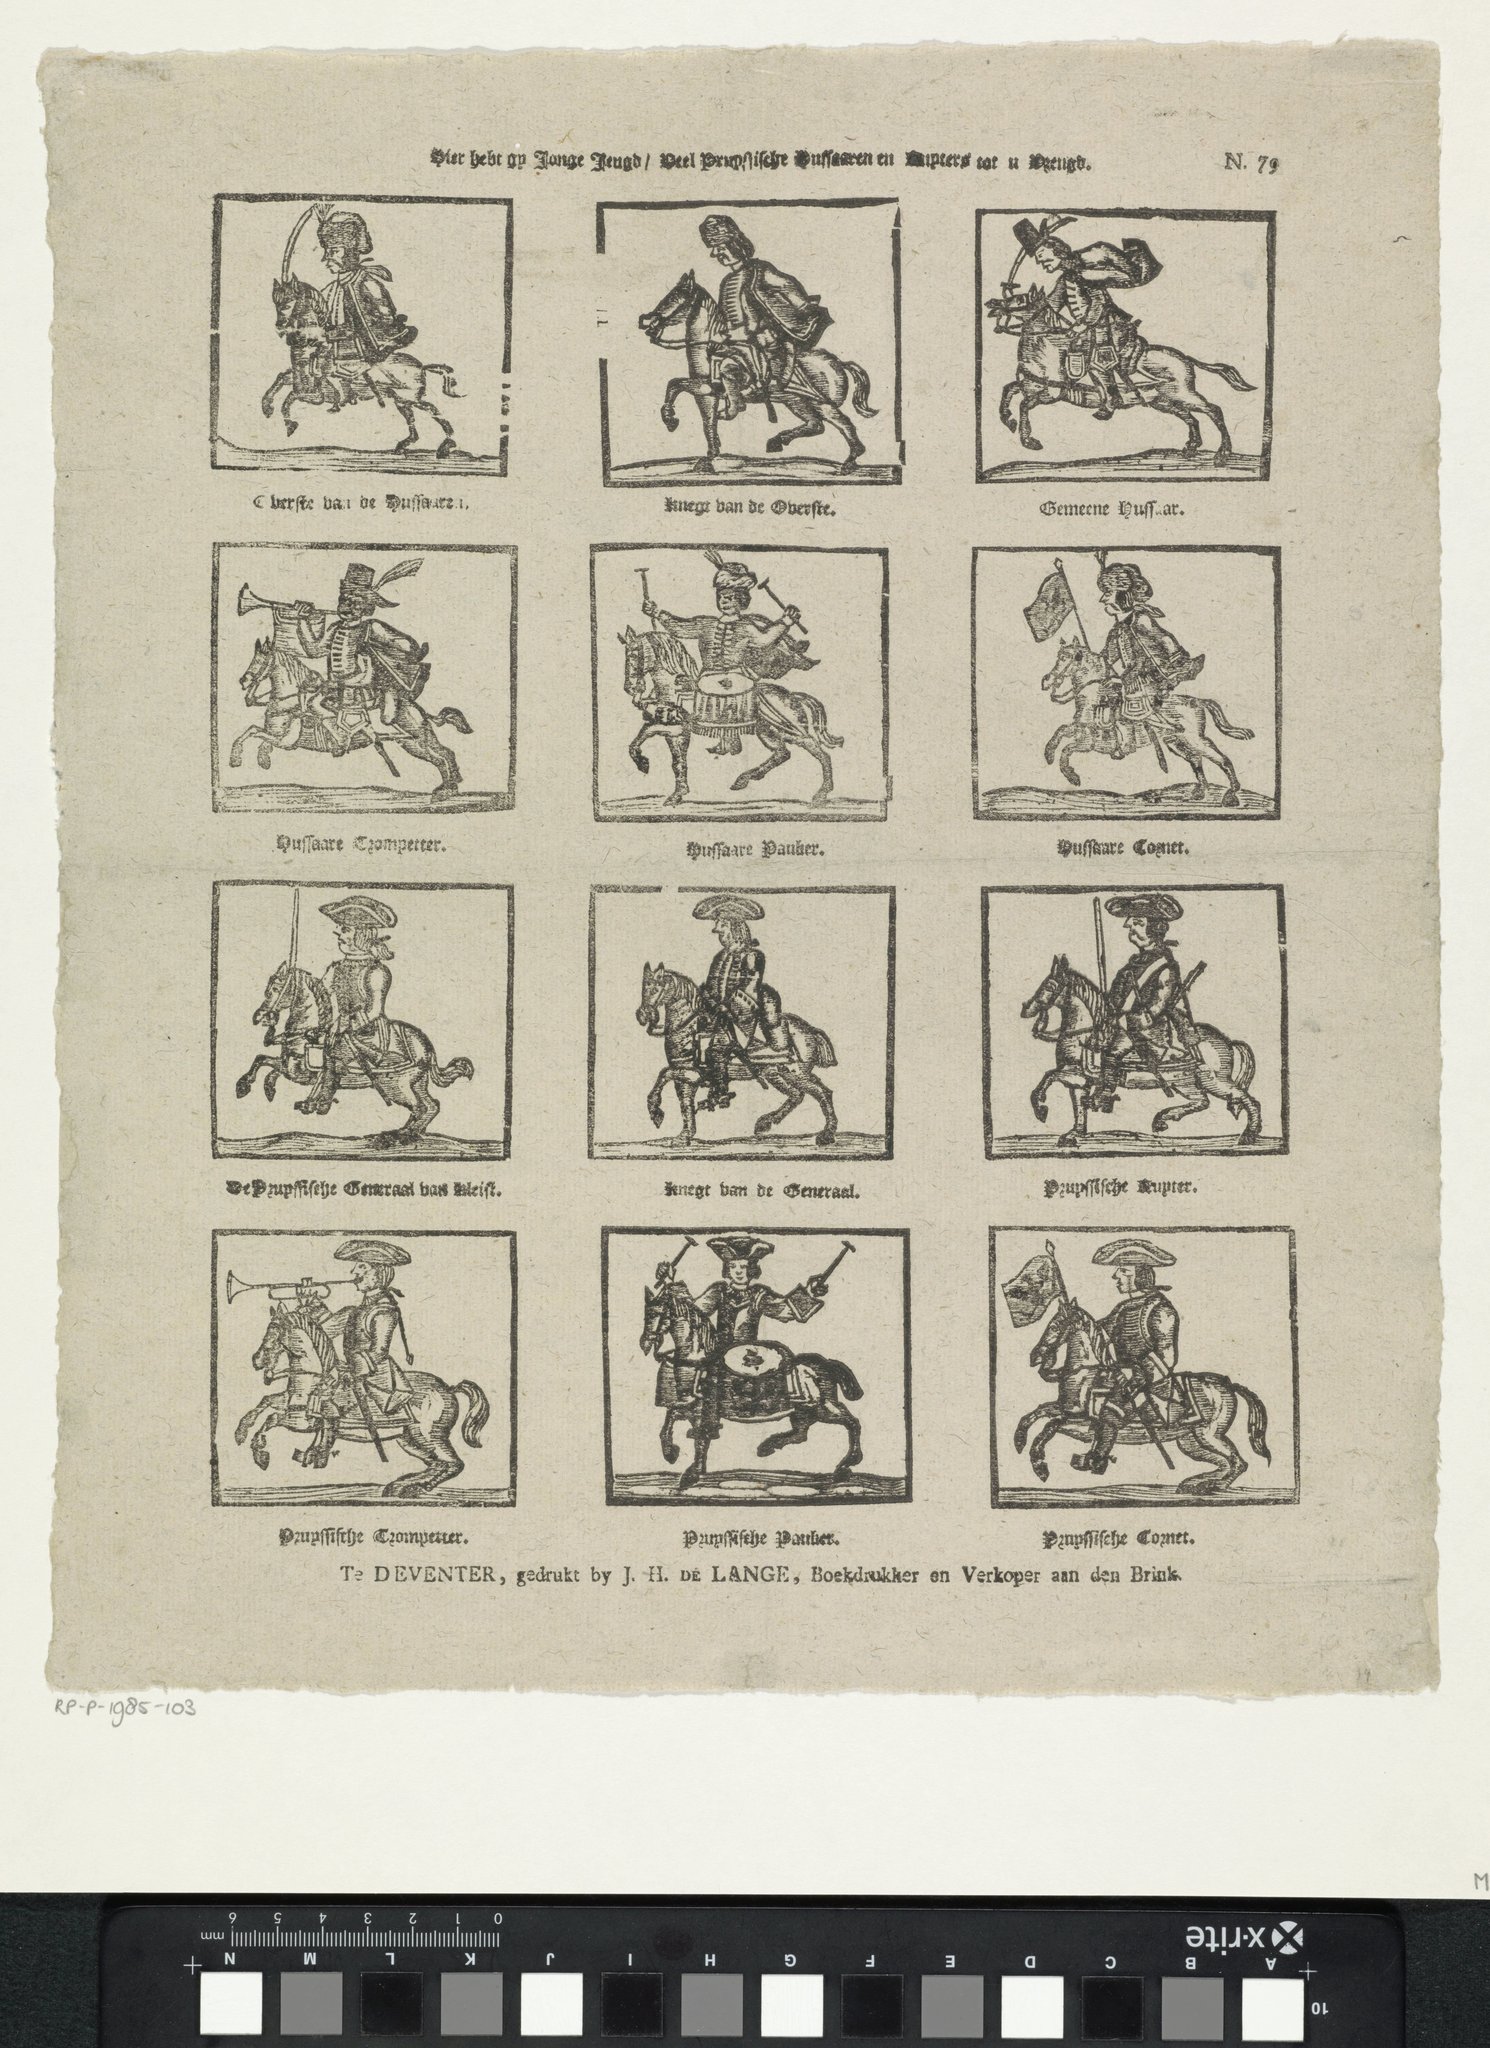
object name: print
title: Hier hebt gij Jonge Jeugd / veel Pruyssische hussaeren en ruyters tot u vreugd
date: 1787-1822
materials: paper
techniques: letterpress printing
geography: deventer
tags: riding a horse, ass, or mule; rider, horseman, warfare; military affairs (+ cavalry, horsemen), the soldier; the soldier's life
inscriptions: collector's mark: Lugt 2760, collector's mark: Lugt 2228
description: Blad met 12 voorstellingen van militairen (huzaren) en ruiters te paard. Onder elke afbeelding een onderschrift. Genummerd rechtsboven: N. 79.